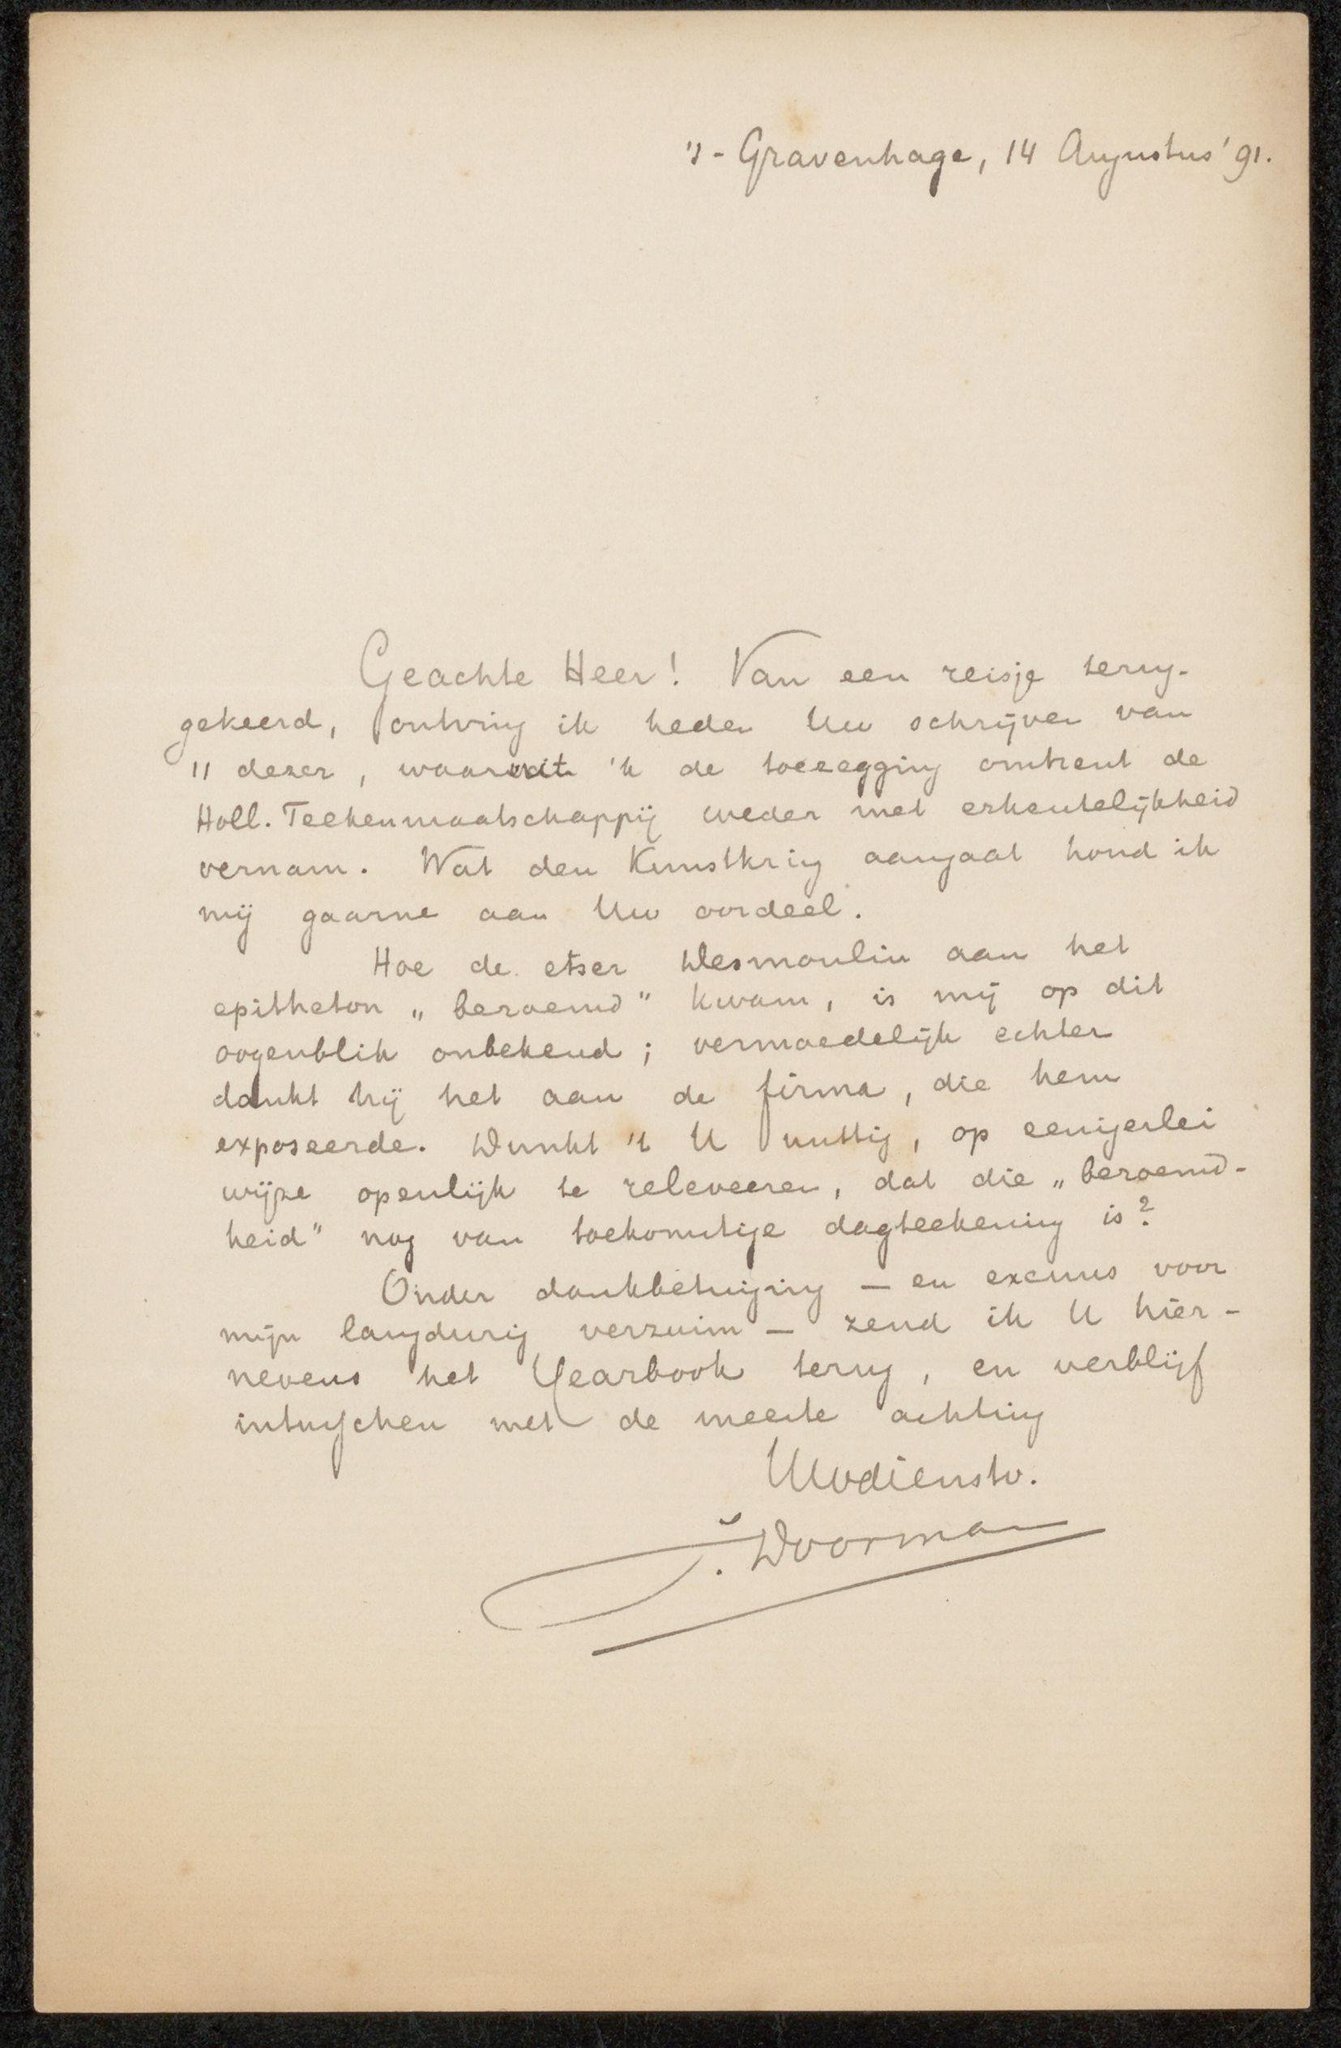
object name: letter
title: Brief aan Philip Zilcken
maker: j. doorman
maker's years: -1913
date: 1891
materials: ink, paper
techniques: pen, writing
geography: the hague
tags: venice, print maker, fernand desmoulin, the hague, painter, philip zilcken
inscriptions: collector's mark: ‘RPK’